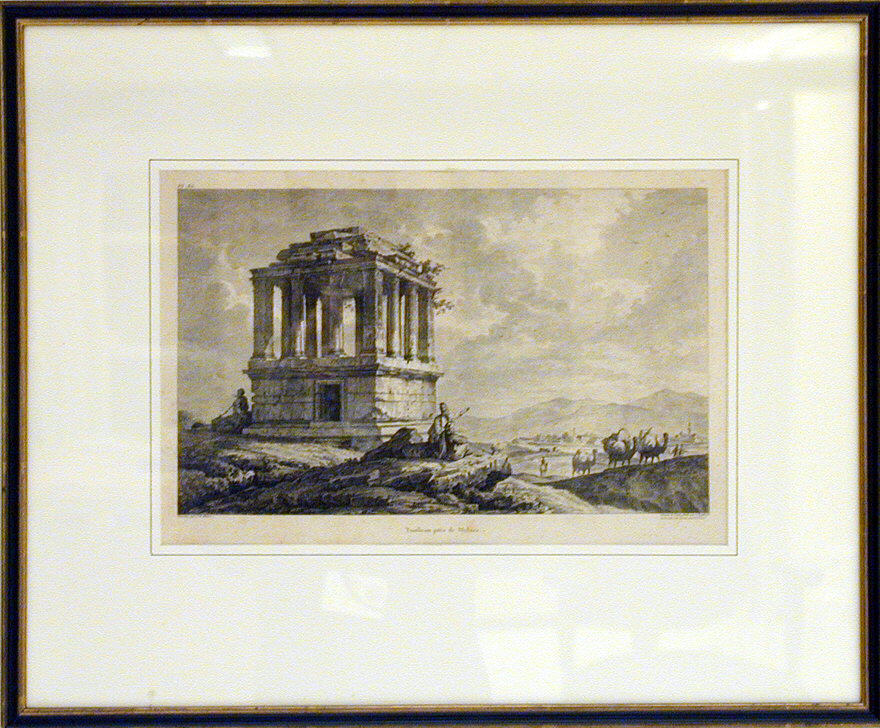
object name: engraving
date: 1701-1800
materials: ink, paper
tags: ruins,maps